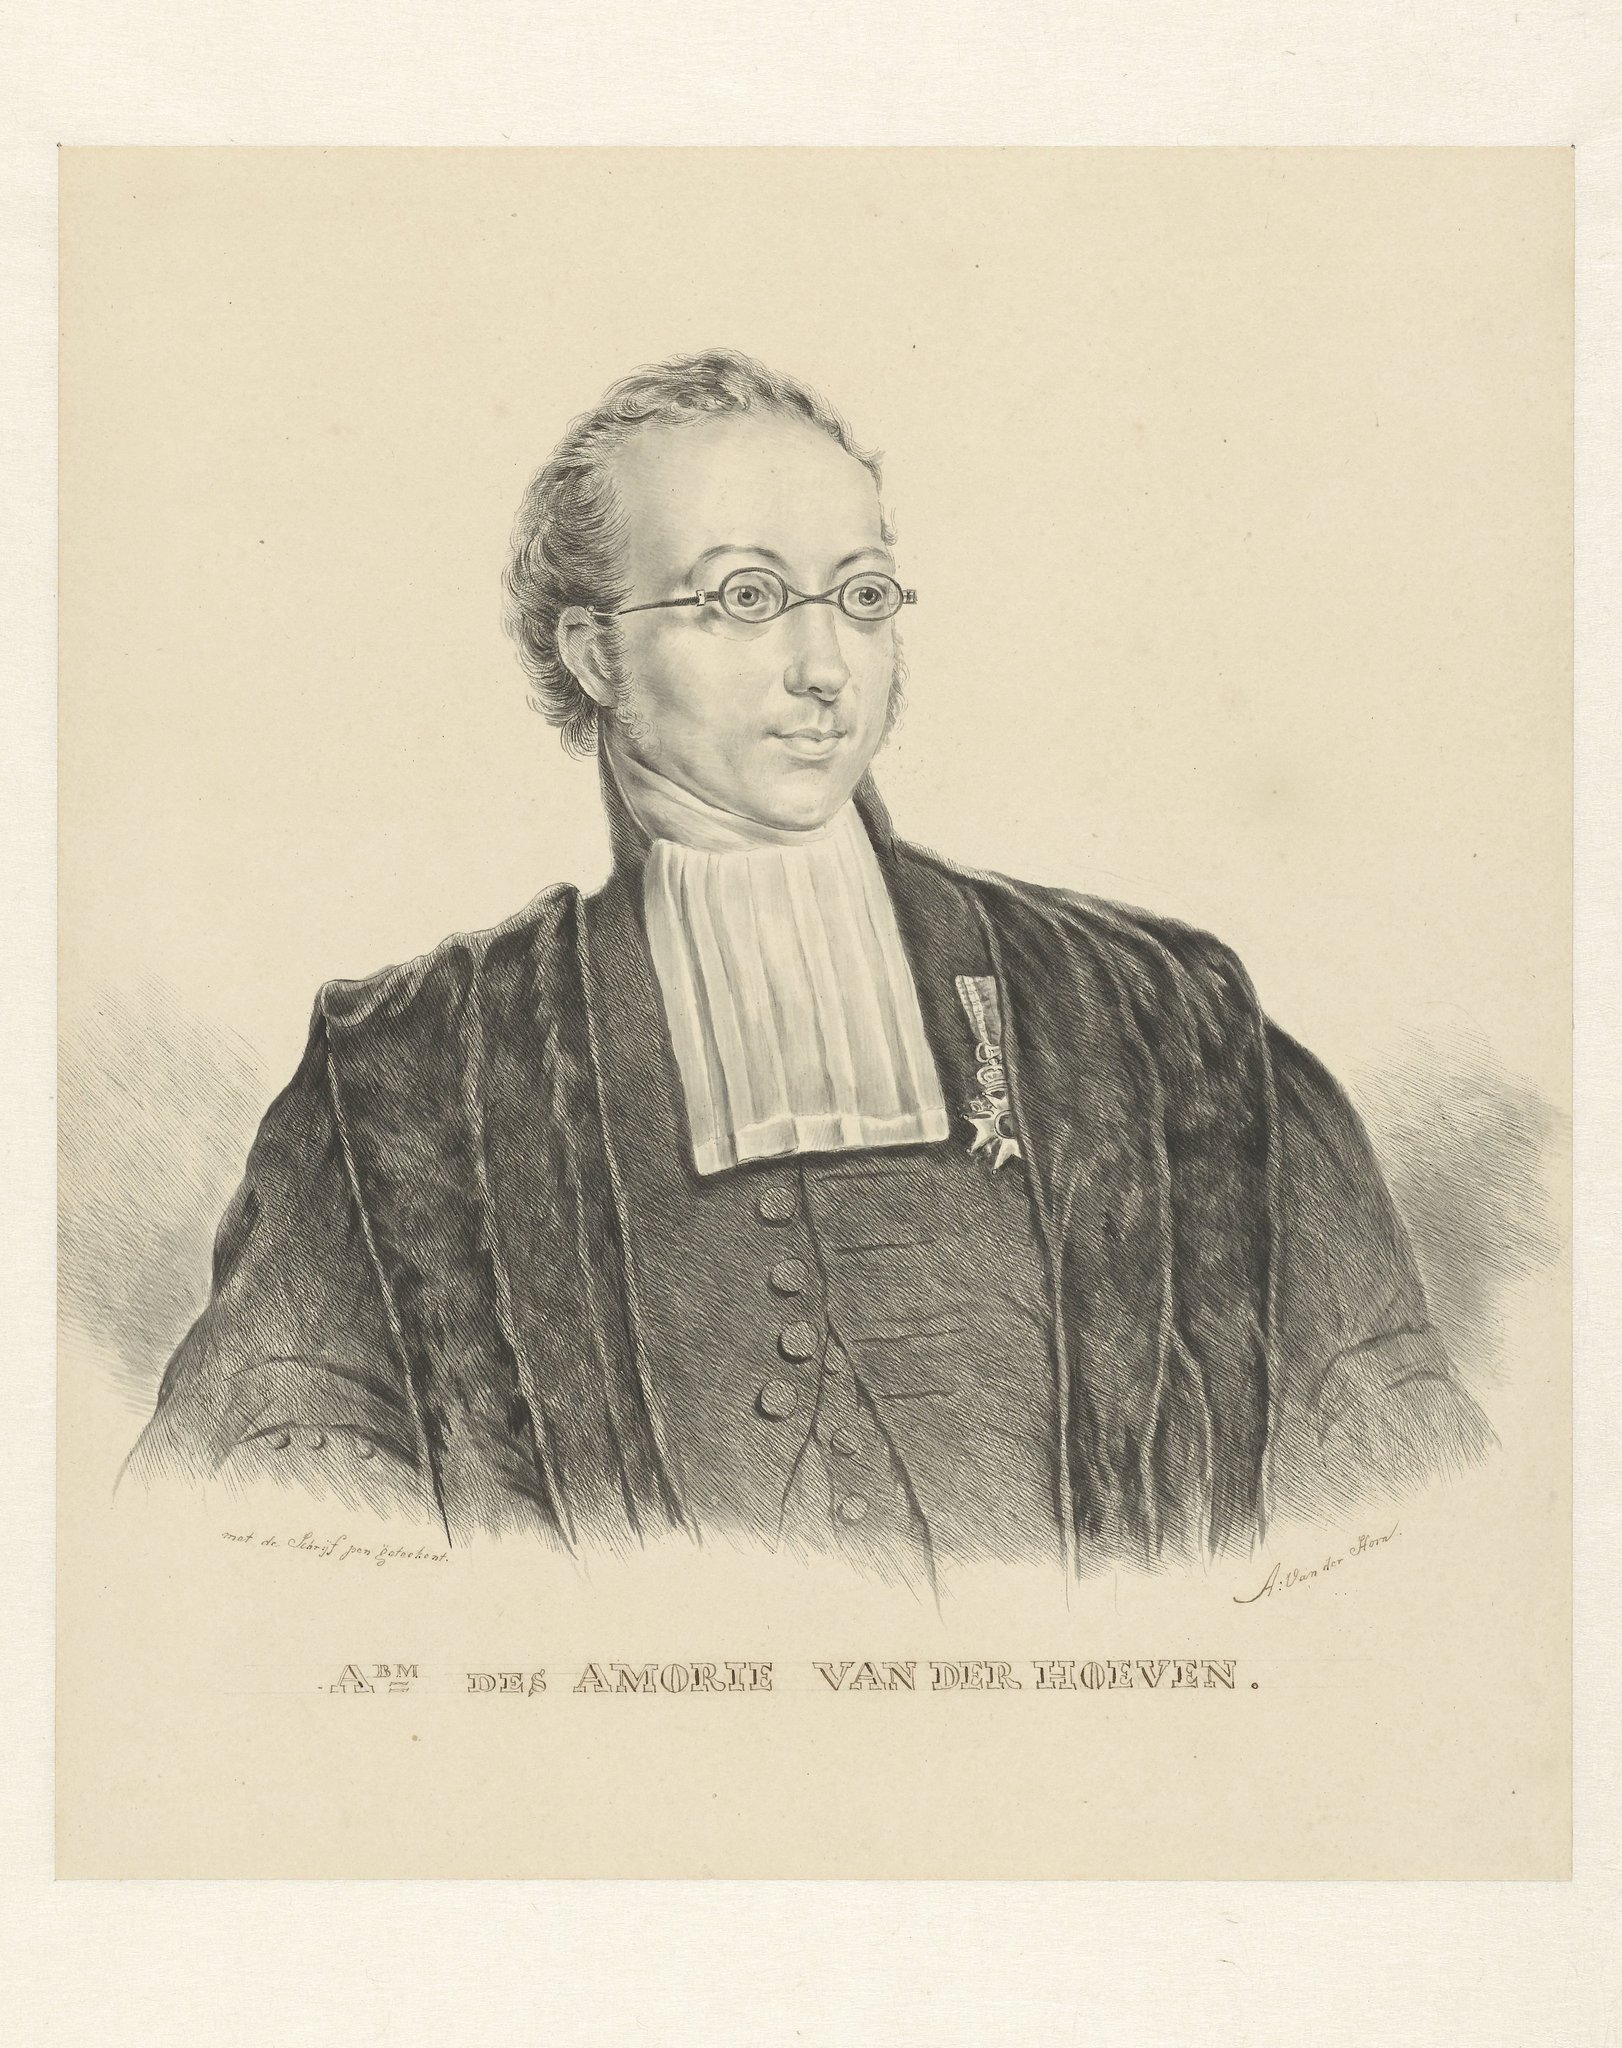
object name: drawing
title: Portret van Abraham des Amorie van der Hoeven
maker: abram van der horn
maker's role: draughtsman, print maker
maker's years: 1782-1867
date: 1792-1867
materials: ink, paper, pencil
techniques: brush, pen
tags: historical persons